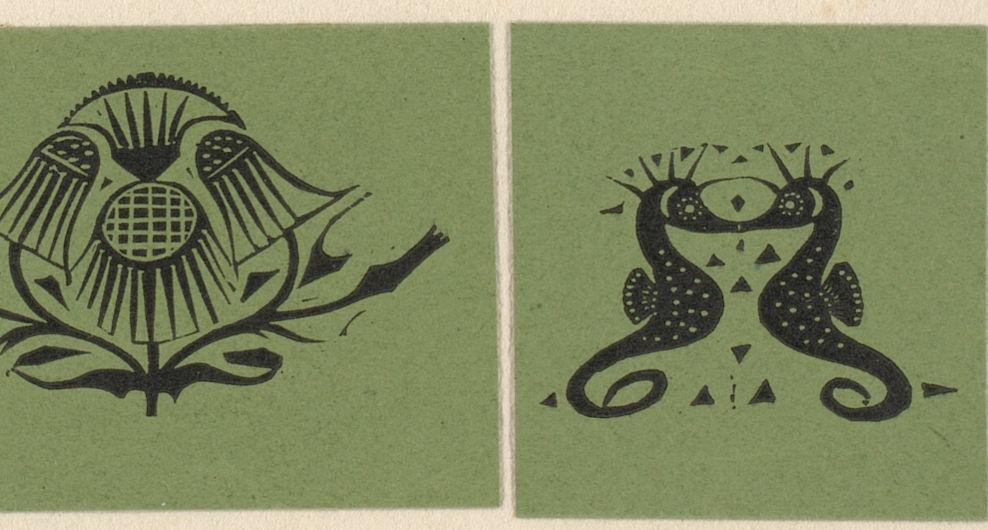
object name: print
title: Sluitvignet met twee zeepaardjes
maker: gerrit willem dijsselhof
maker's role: designer, draughtsman, print maker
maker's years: 1866-1924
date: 1893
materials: paper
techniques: galvanoplasty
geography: amsterdam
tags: bony fishes: hippocampus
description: Sluitvignet gebruikt in: Crane, Walter. Kunst en samenleving. [Vertaald uit het Engels door] Jan Veth. Amsterdam: Scheltema & Holkema's Boekhandel, 1894 [1893], p. 49. Later zijn deze afbeeldingen door de uitgever veelvuldig gebruikt voor andere uitgaven. Zie bijvoorbeeld RP-P-1969-415, een catalogus van de in 1894 bij Scheltema & Holkema's Boekhandel verkrijgbare publicaties.